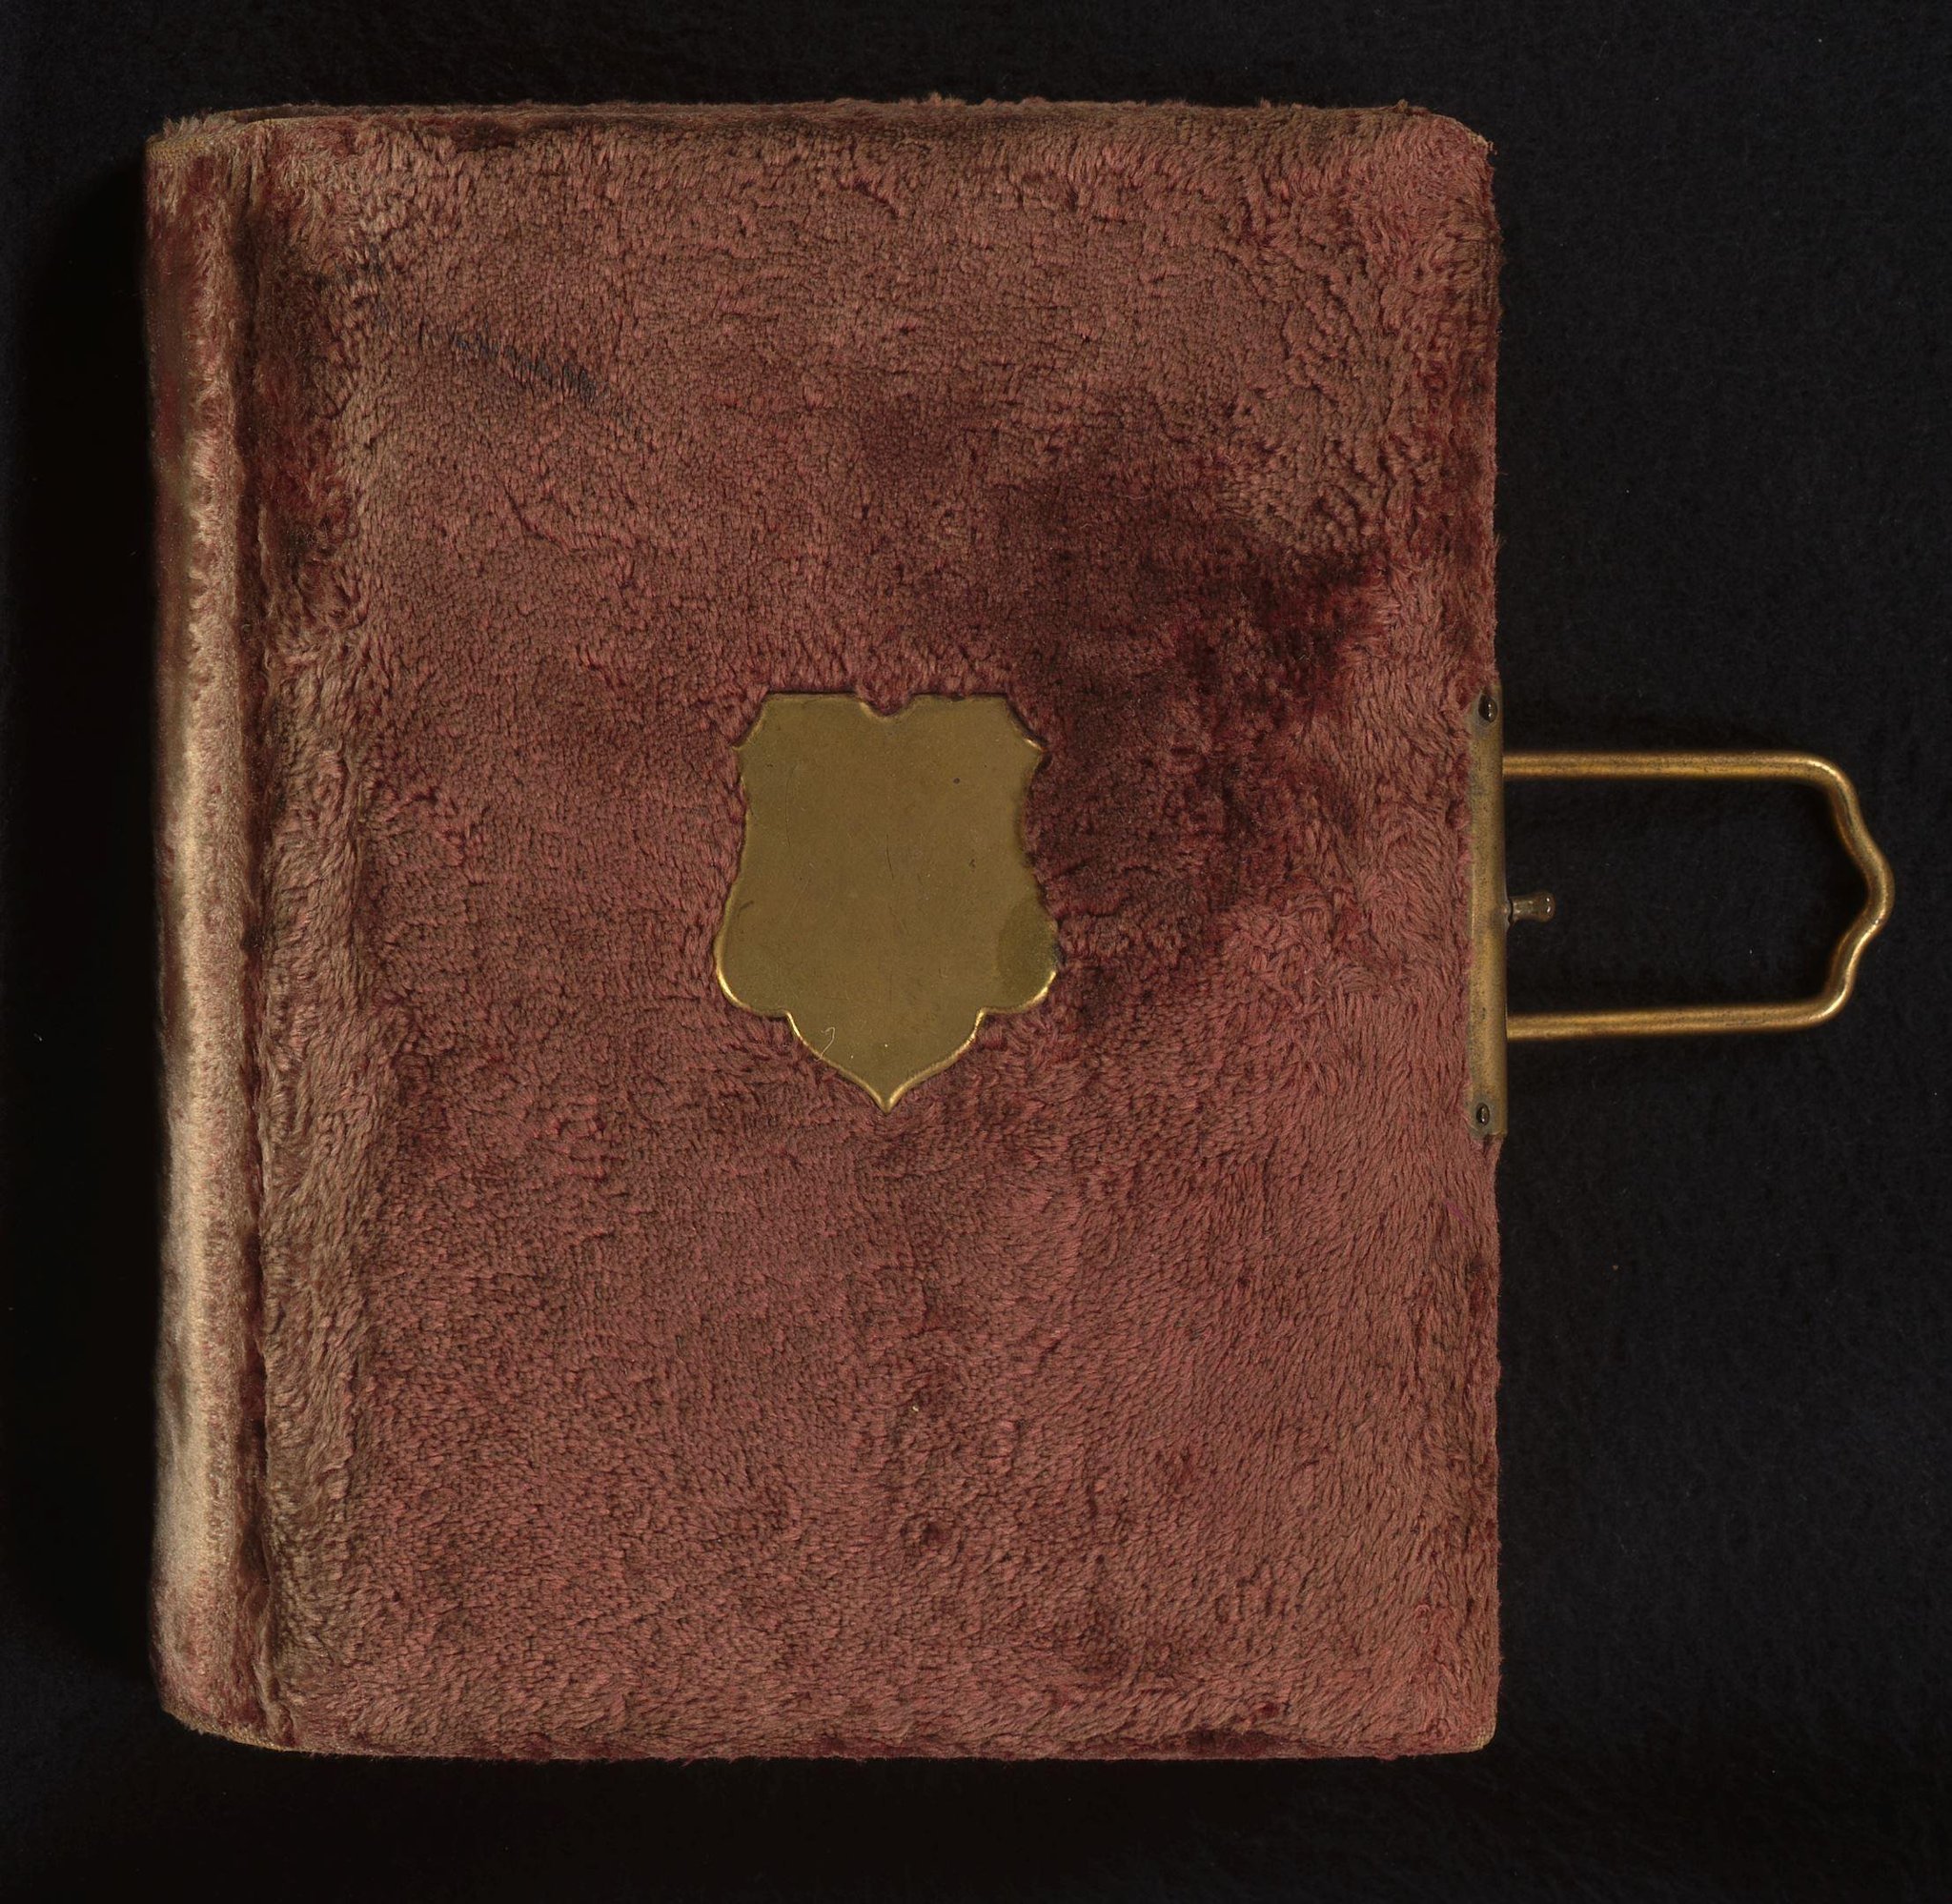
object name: photograph album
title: Familiealbum met 38 foto's (Frans/Belgisch)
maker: Anonymous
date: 1913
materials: cardboard, metal, photographic support, textile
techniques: albumen print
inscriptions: inscription: ‘Dienst/ Verspreide/ Rijkskollekties (...)’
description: Fotoalbum met 40 pagina's met in totaal 38 foto's, waarvan er vijf los achterin het album zitten. Het album bevat voornamelijk portretten, van een Franse of Belgische familie, waarvan veel cartes-de-visite.